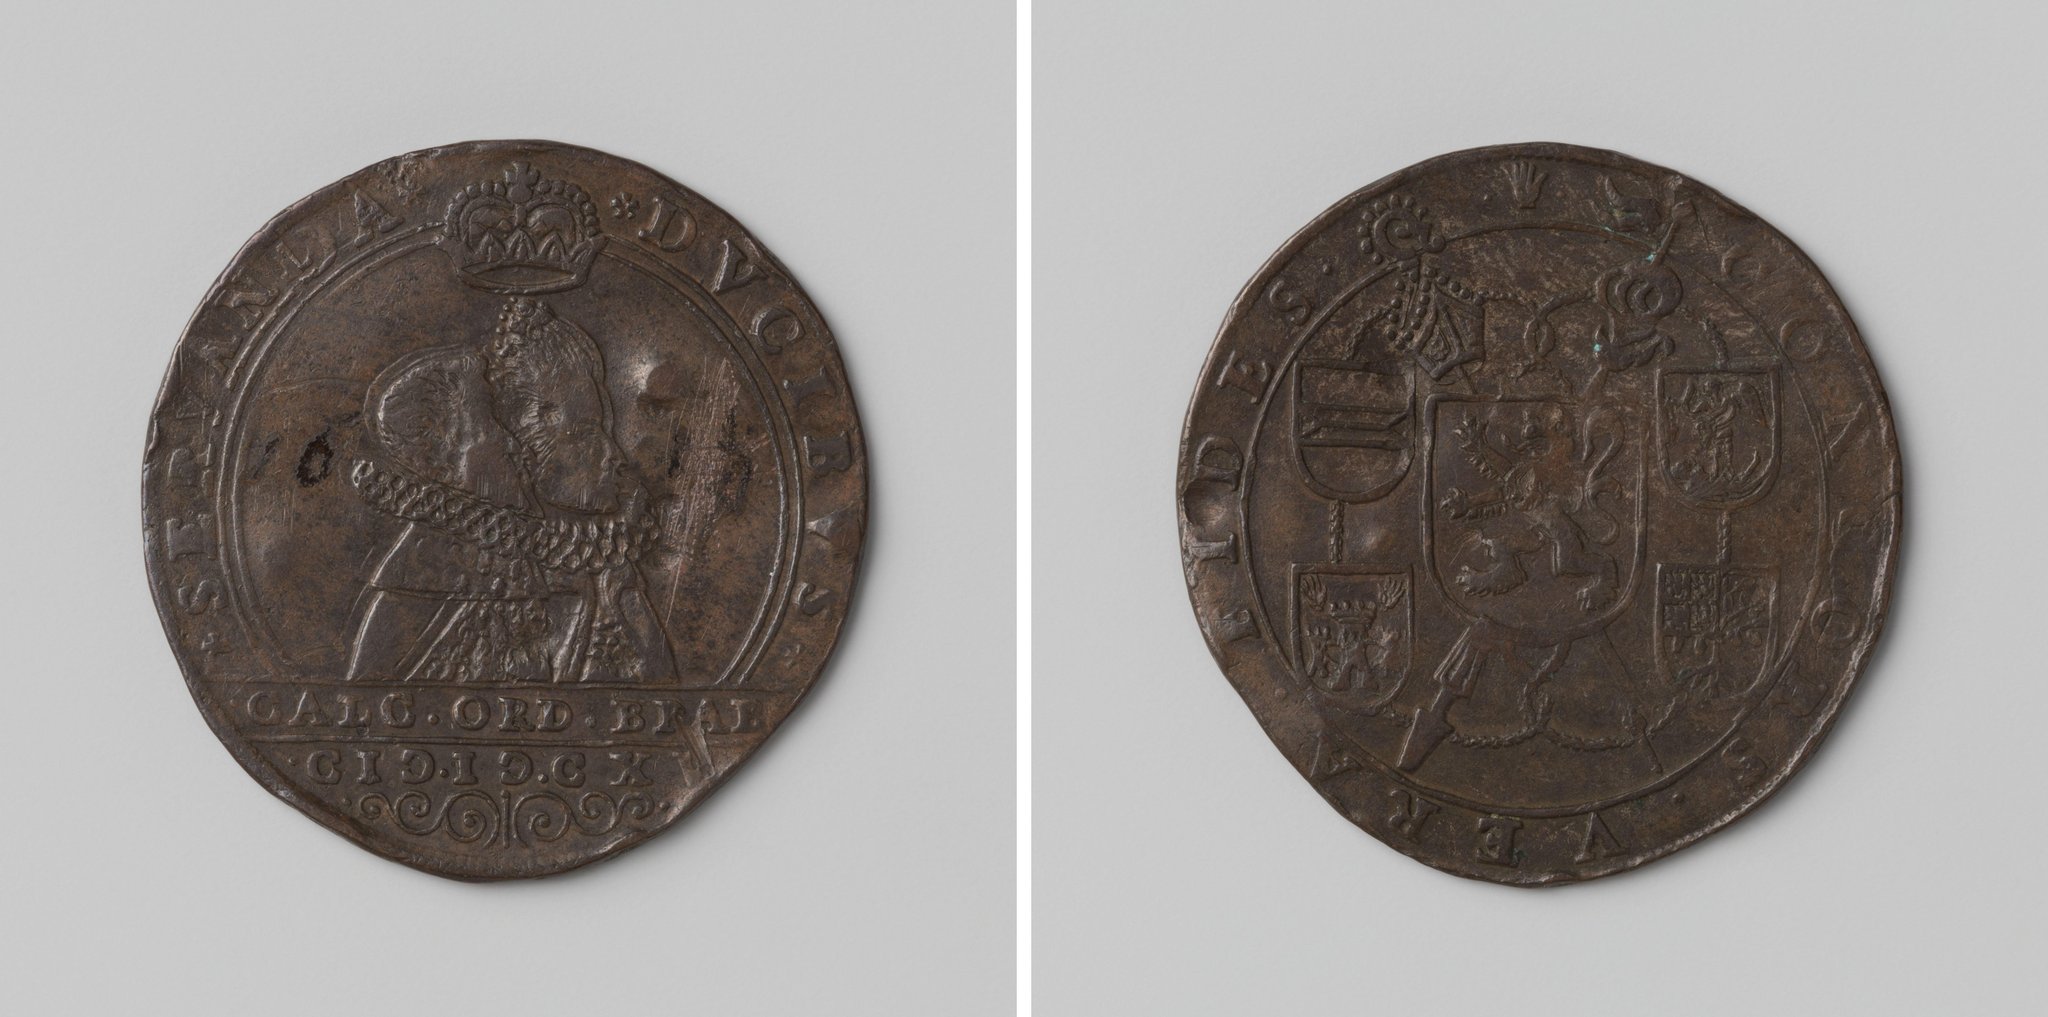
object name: jeton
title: Albrecht en Isabella van Oostenrijk, rekenpenning geslagen op last van de Staten van Brabant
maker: Anonymous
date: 1615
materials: copper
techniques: striking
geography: antwerp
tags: infante van spanje isabella clara eugenia, brussels, albrecht aartshertog van oostenrijk, brabant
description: Koperen penning. Voorzijde: borststukken van man en vrouw onder kroon binnen omschrift; afsnede: opschrift boven siermotief. Keerzijde: wapenschild op een gekruiste bisschopsstaf, bekroond met een mijter, en een lans, bekroond met een helm, omgeven door vier met koord samengebonden wapenschilden binnen omschrift